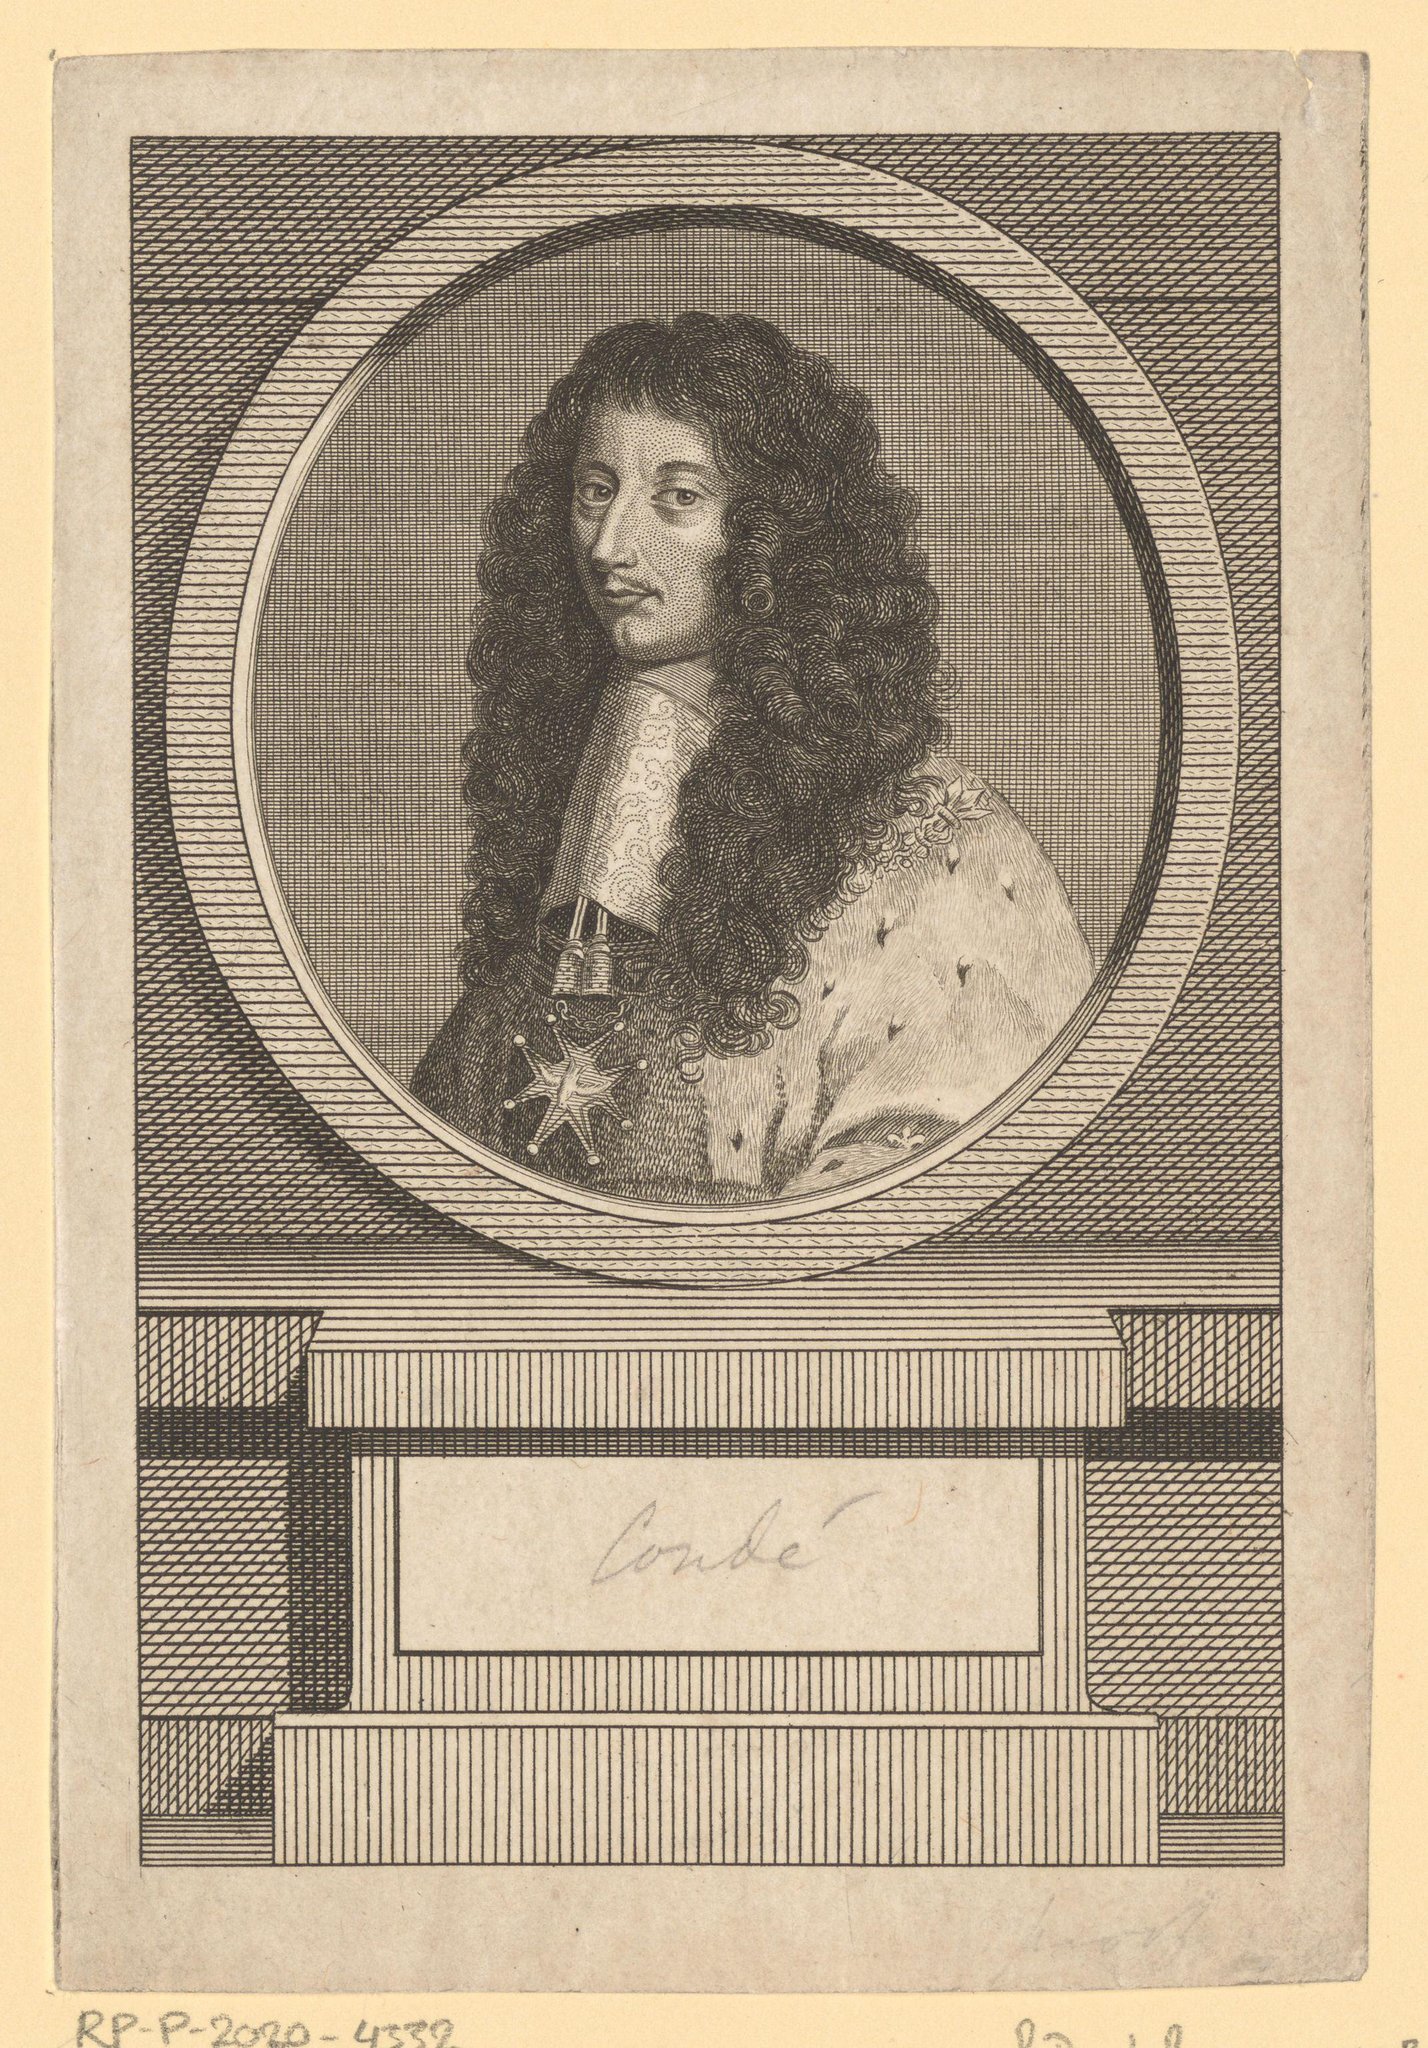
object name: print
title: Portret van Lodewijk II de Bourbon-Condé, hertog van Enghien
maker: Anonymous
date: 1647-1781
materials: paper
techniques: engraving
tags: paris, lodewijk ii de bourbon-condé (hertog van enghien), historical persons